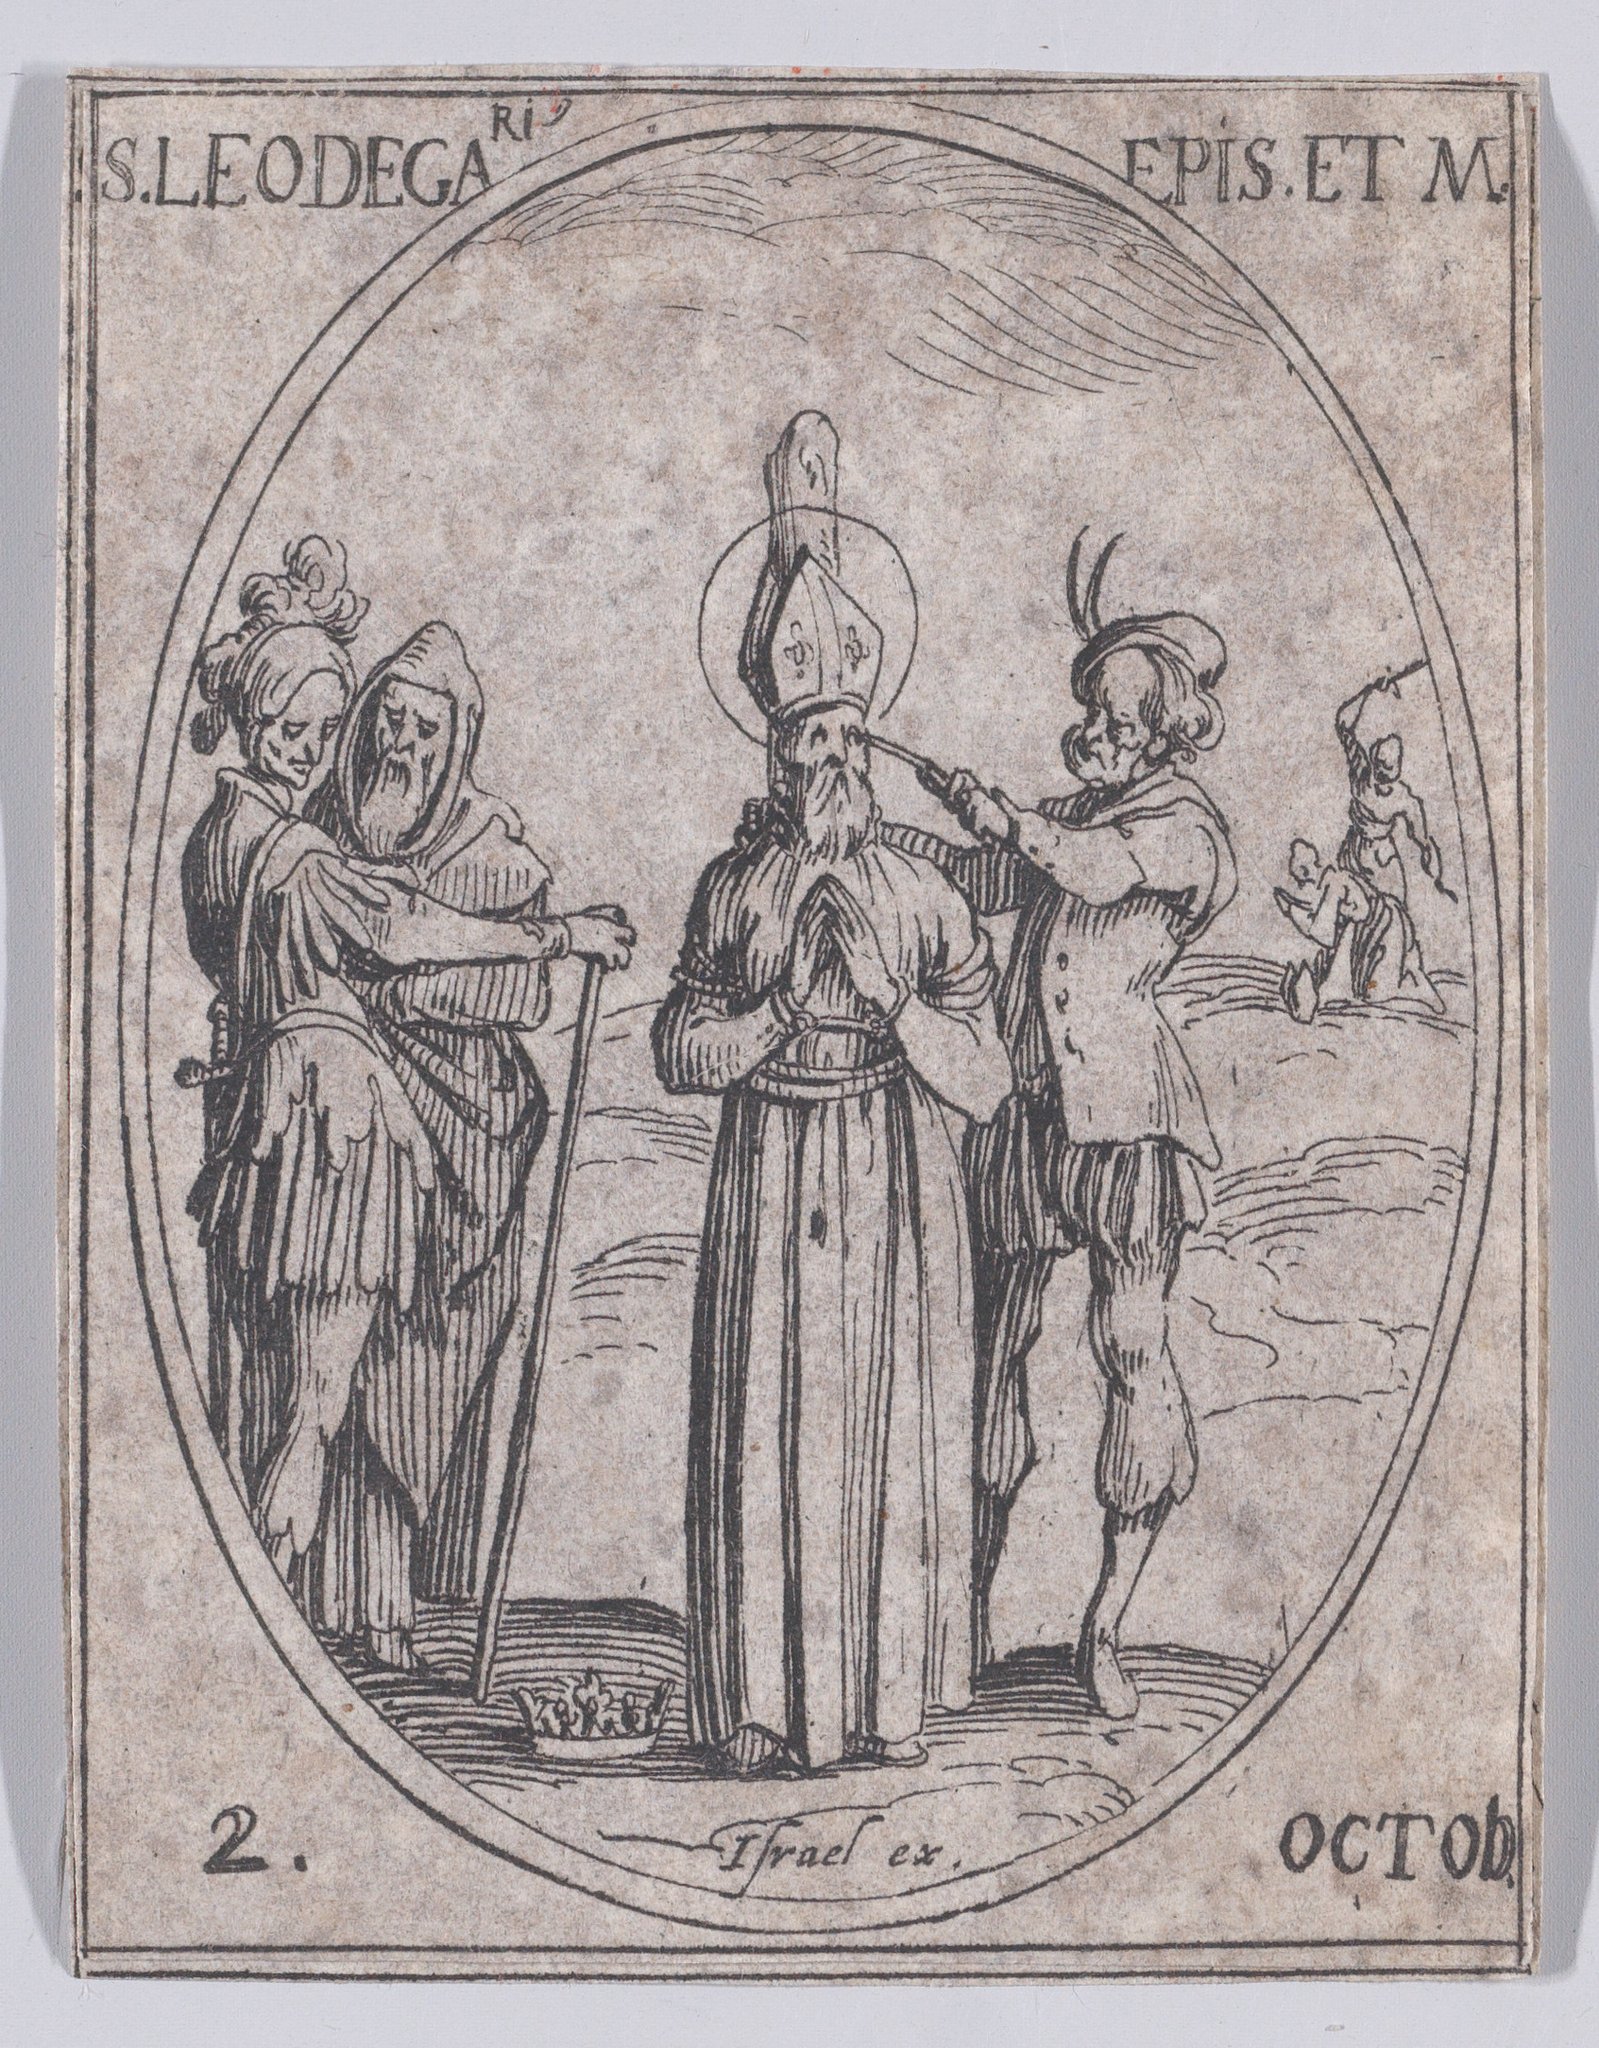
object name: print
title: S. Léger, évêque et martyr (St. Leger, Bishop and Martyr), October 2nd, from "Les Images De Tous Les Saincts et Saintes de L'Année" (Images of All of the Saints and Religious Events of the Year)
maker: jacques callot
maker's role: artist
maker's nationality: french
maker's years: 1592-1635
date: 1636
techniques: etching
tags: men,saints